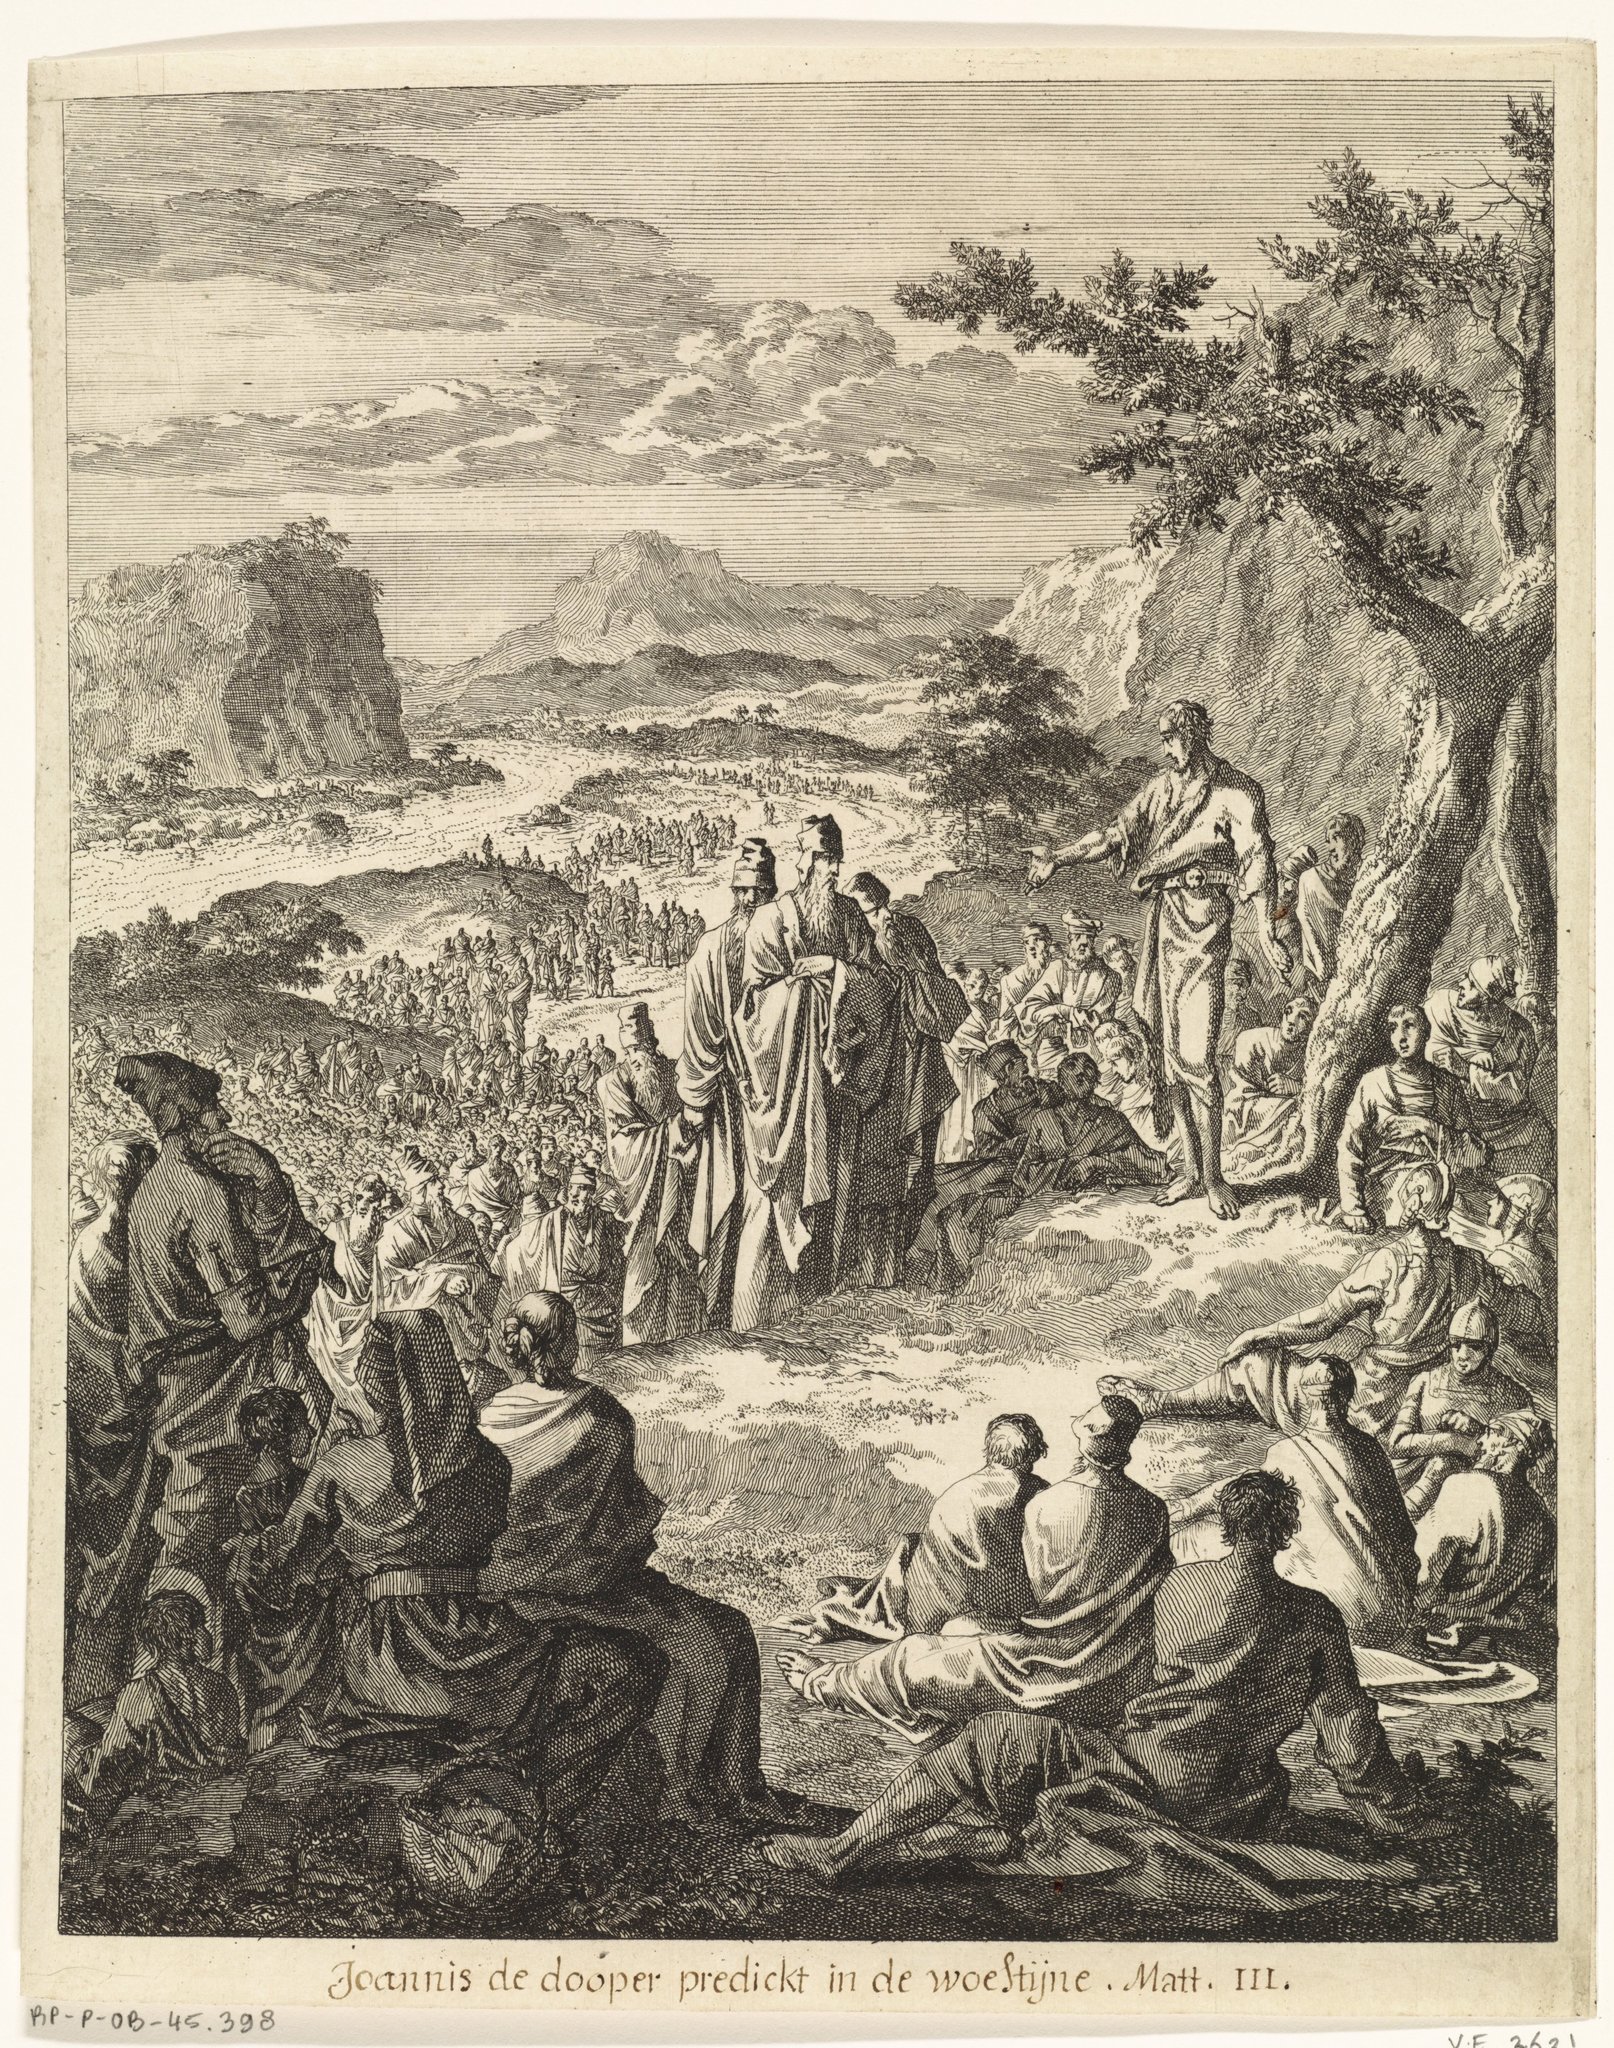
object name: print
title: Prediking van Johannes de Doper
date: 1708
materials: paper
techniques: etching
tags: john the baptist preaching (perhaps christ among the bystanders)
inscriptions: collector's mark: Lugt 2228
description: Proefdruk van een prent welke is opgenomen als illustratie in: Historiae Celebriores Veteris Testamenti. Christoph Weigel, 1708.